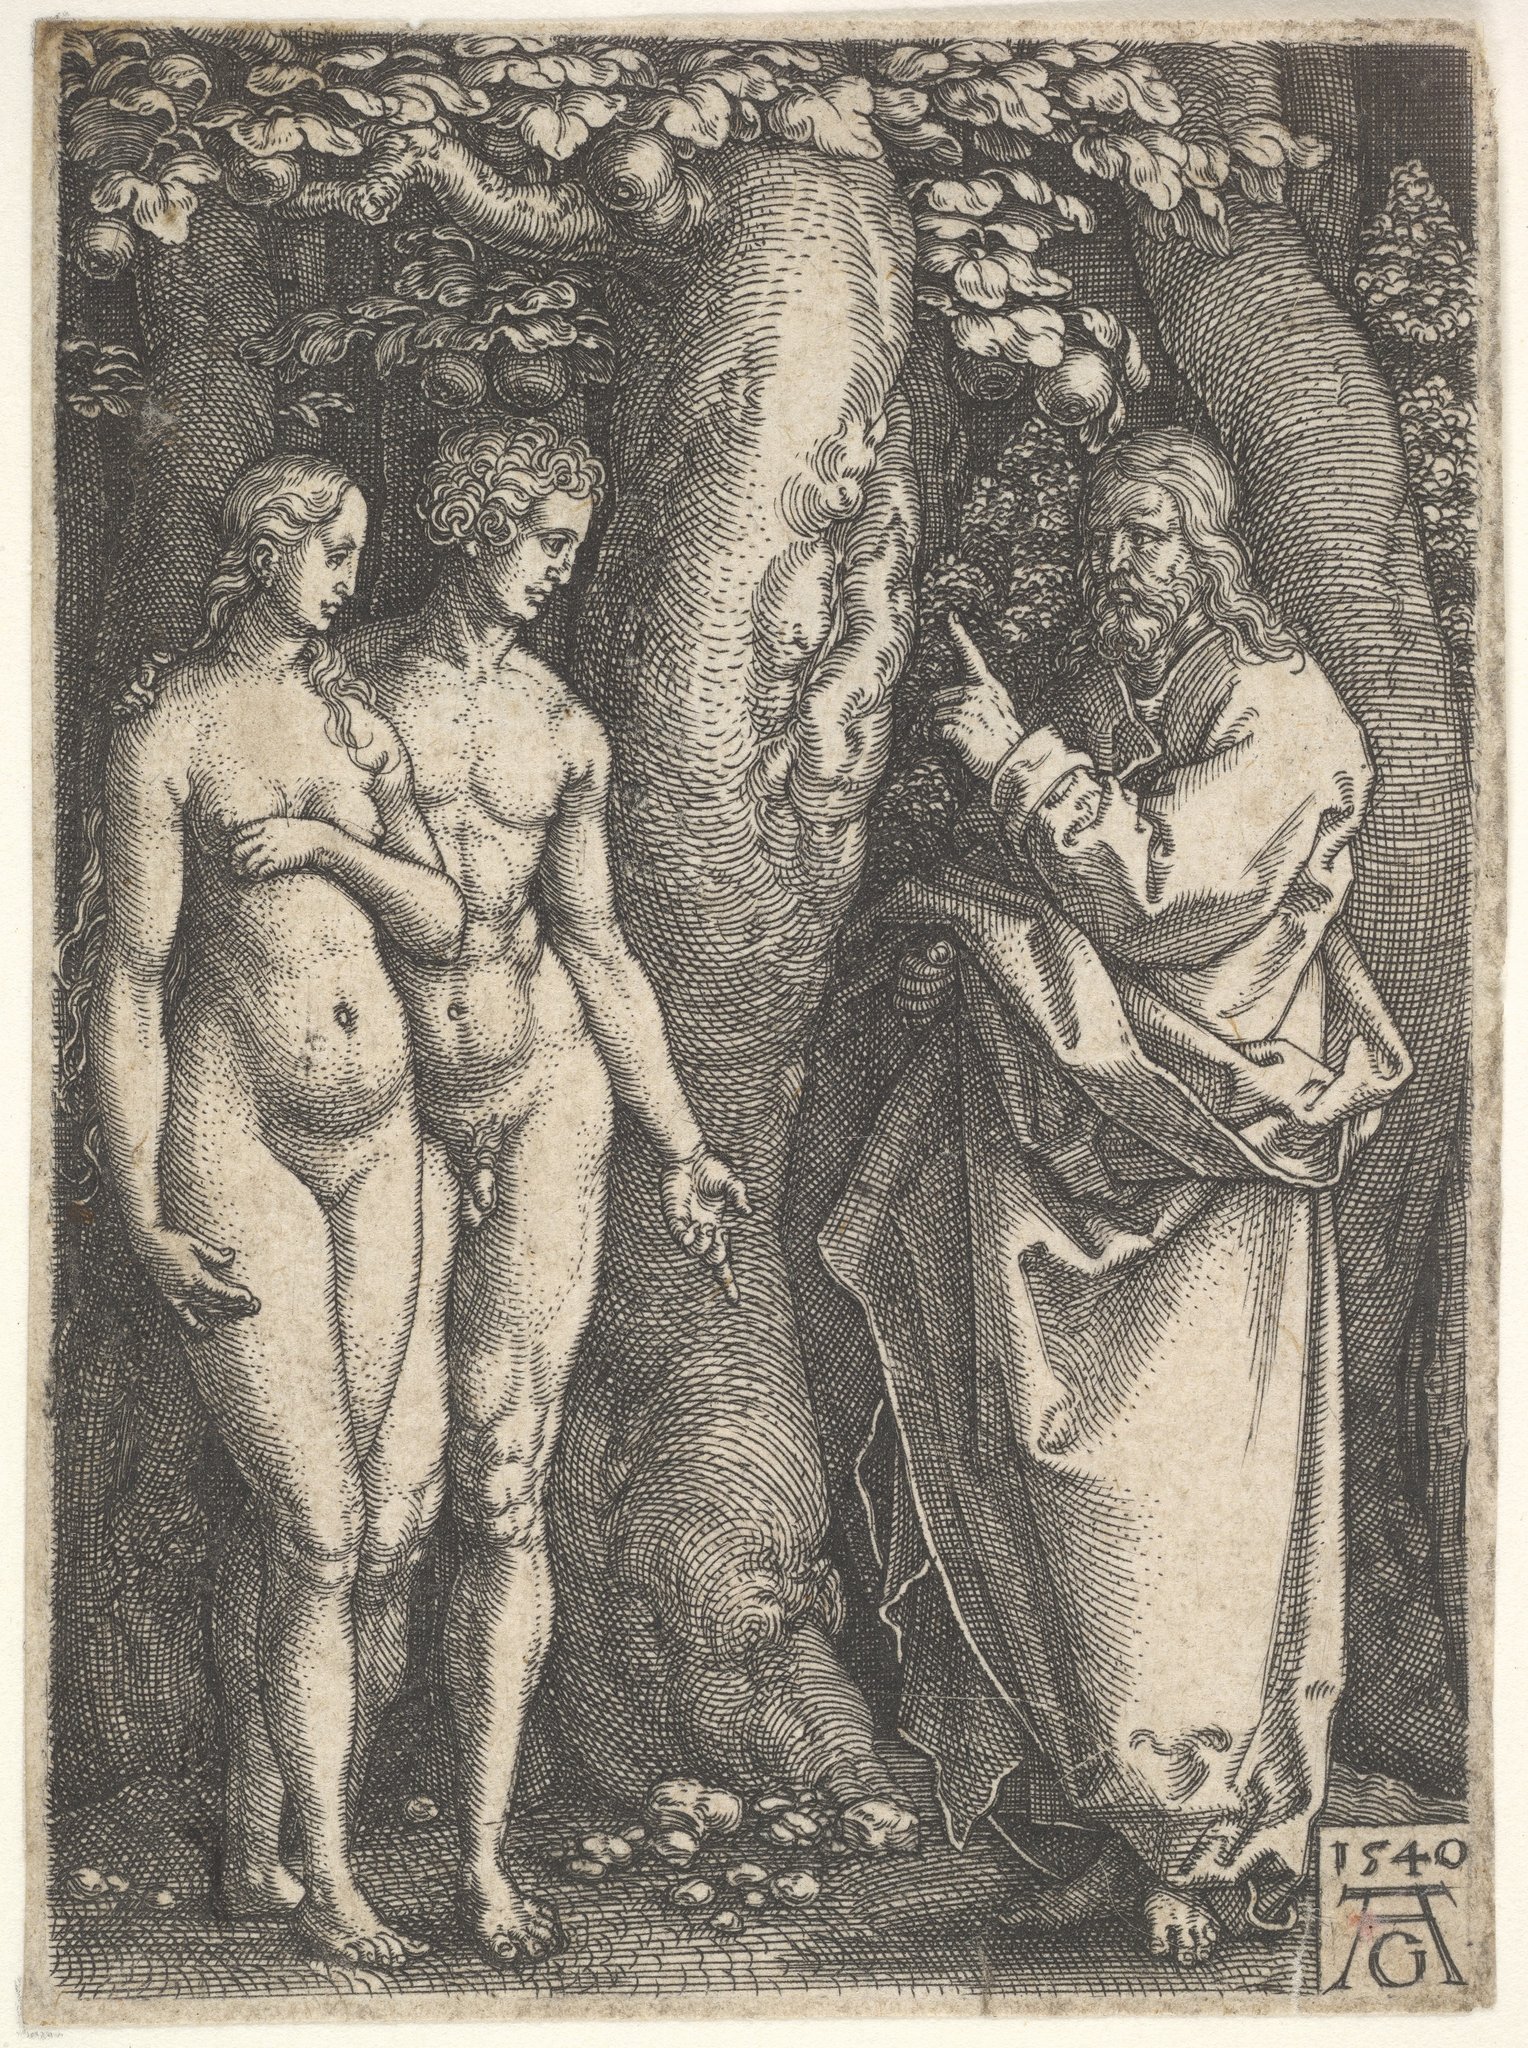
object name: print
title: God at right forbidding the nude Adam and Eve at left to eat from the tree of knowledge in center, from "Adam and Eve"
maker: heinrich aldegrever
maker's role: artist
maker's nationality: german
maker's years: 1502-1561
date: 1540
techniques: engraving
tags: adam,eve